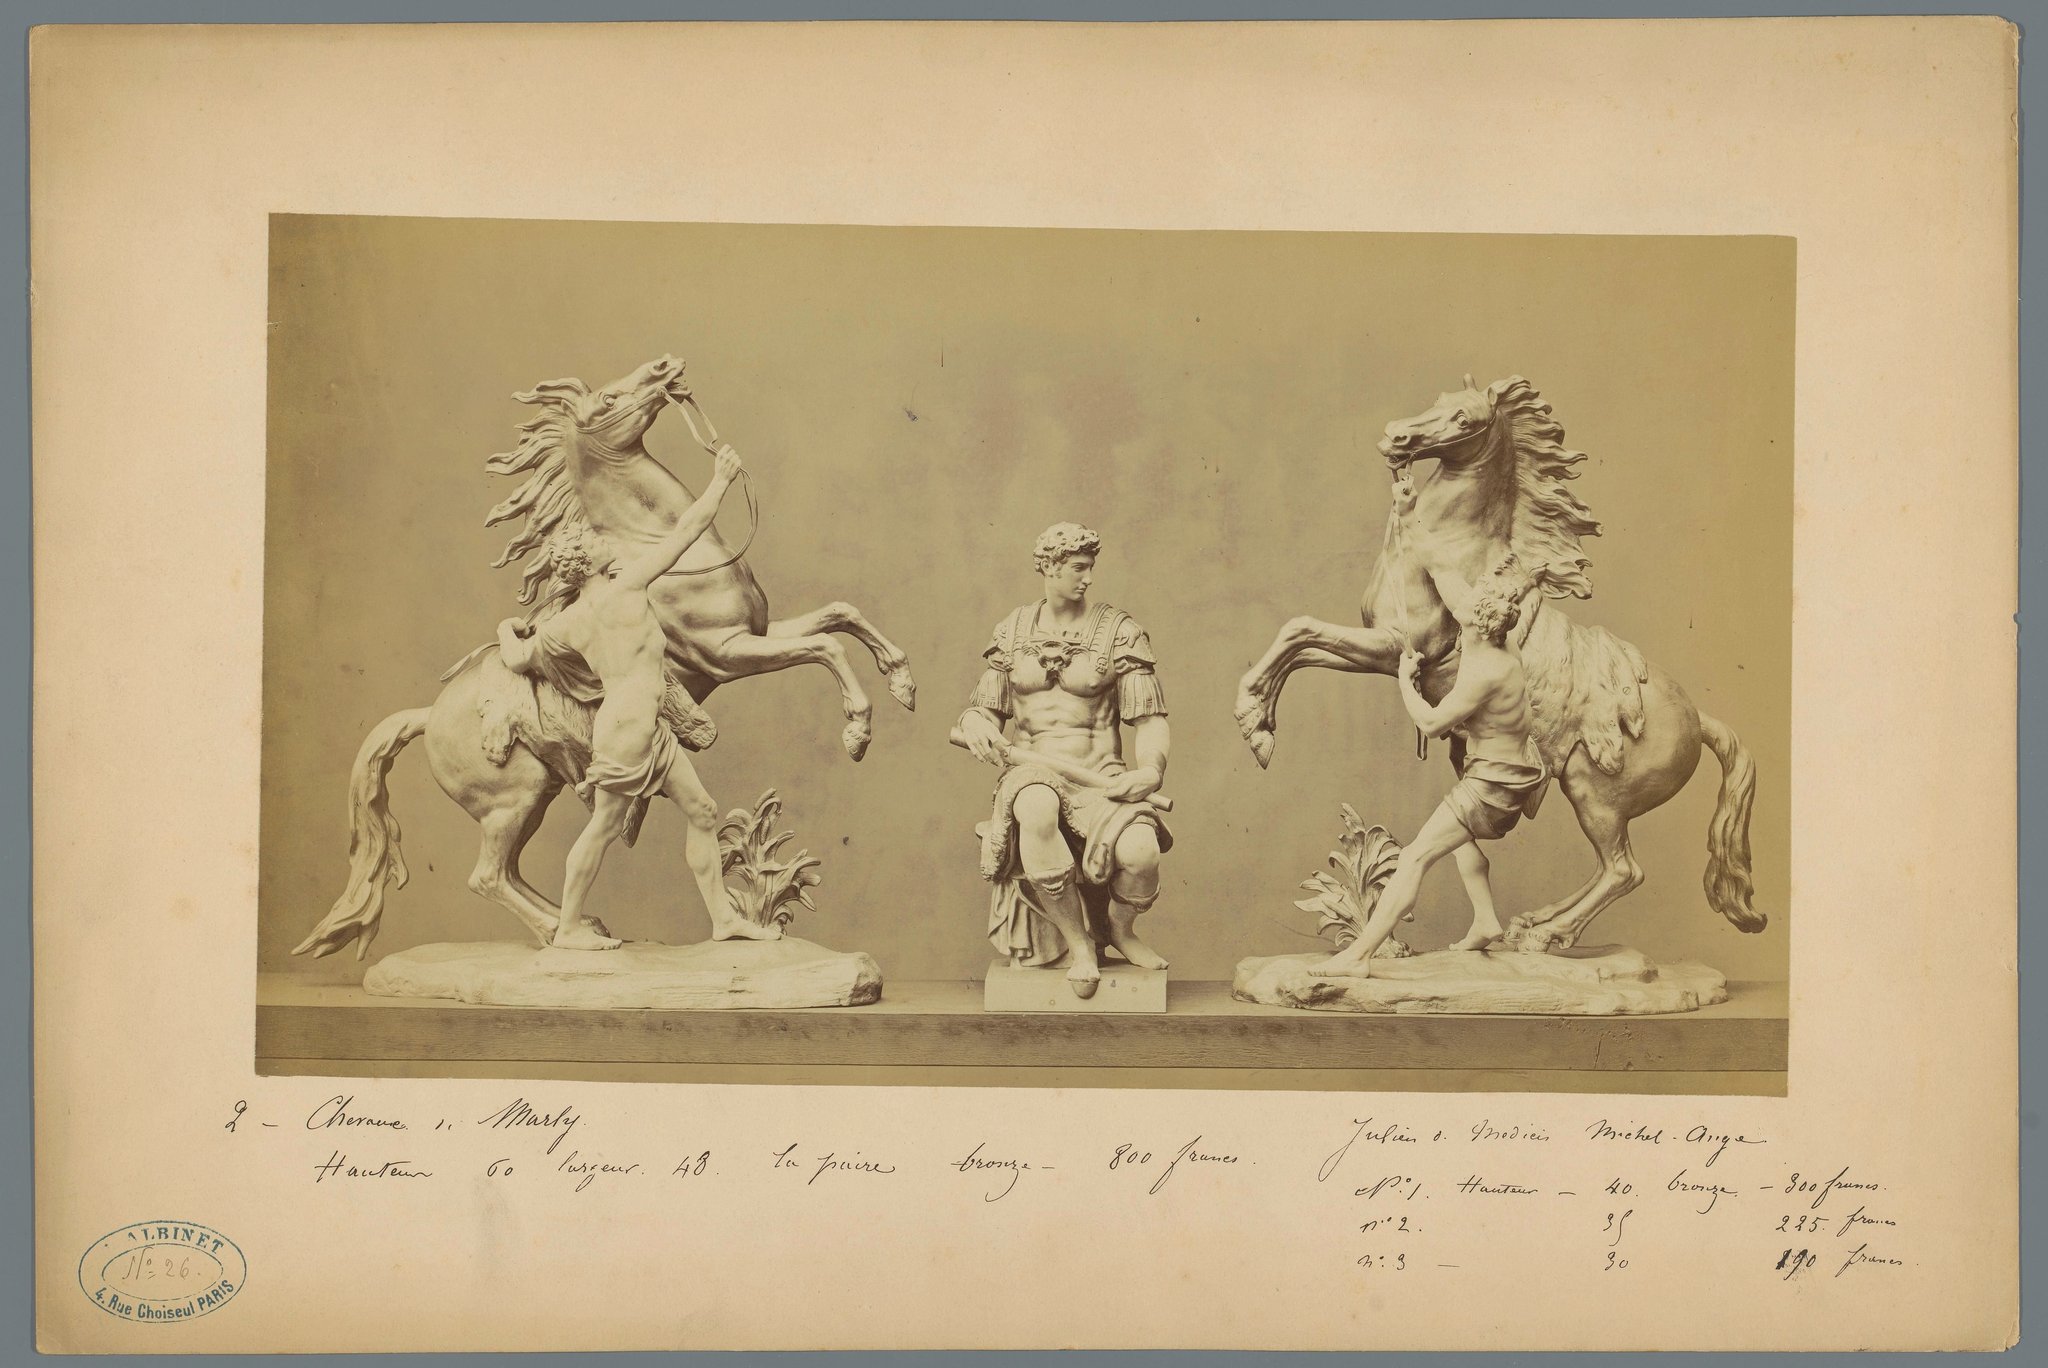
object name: photograph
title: Drie sculpturen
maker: Anonymous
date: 1875-1900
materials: cardboard, photographic support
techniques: albumen print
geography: europe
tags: piece of sculpture, reproduction of a piece of sculpture (+ sculpture), horse, europe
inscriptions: name: ‘[...]LBINET 4. Rue Choiseul PARIS’, collector's mark: Lugt 3937, inscription: ‘2 - Chevaue ,, Marly Julien d. Inodieis Michel. Ange’, number: ‘No 26.’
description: Links en rechts: reproducties van de de Chevaux de Marly , midden: een reproductie van een sculptuur van Giuliano de' Medici door Michelangelo.